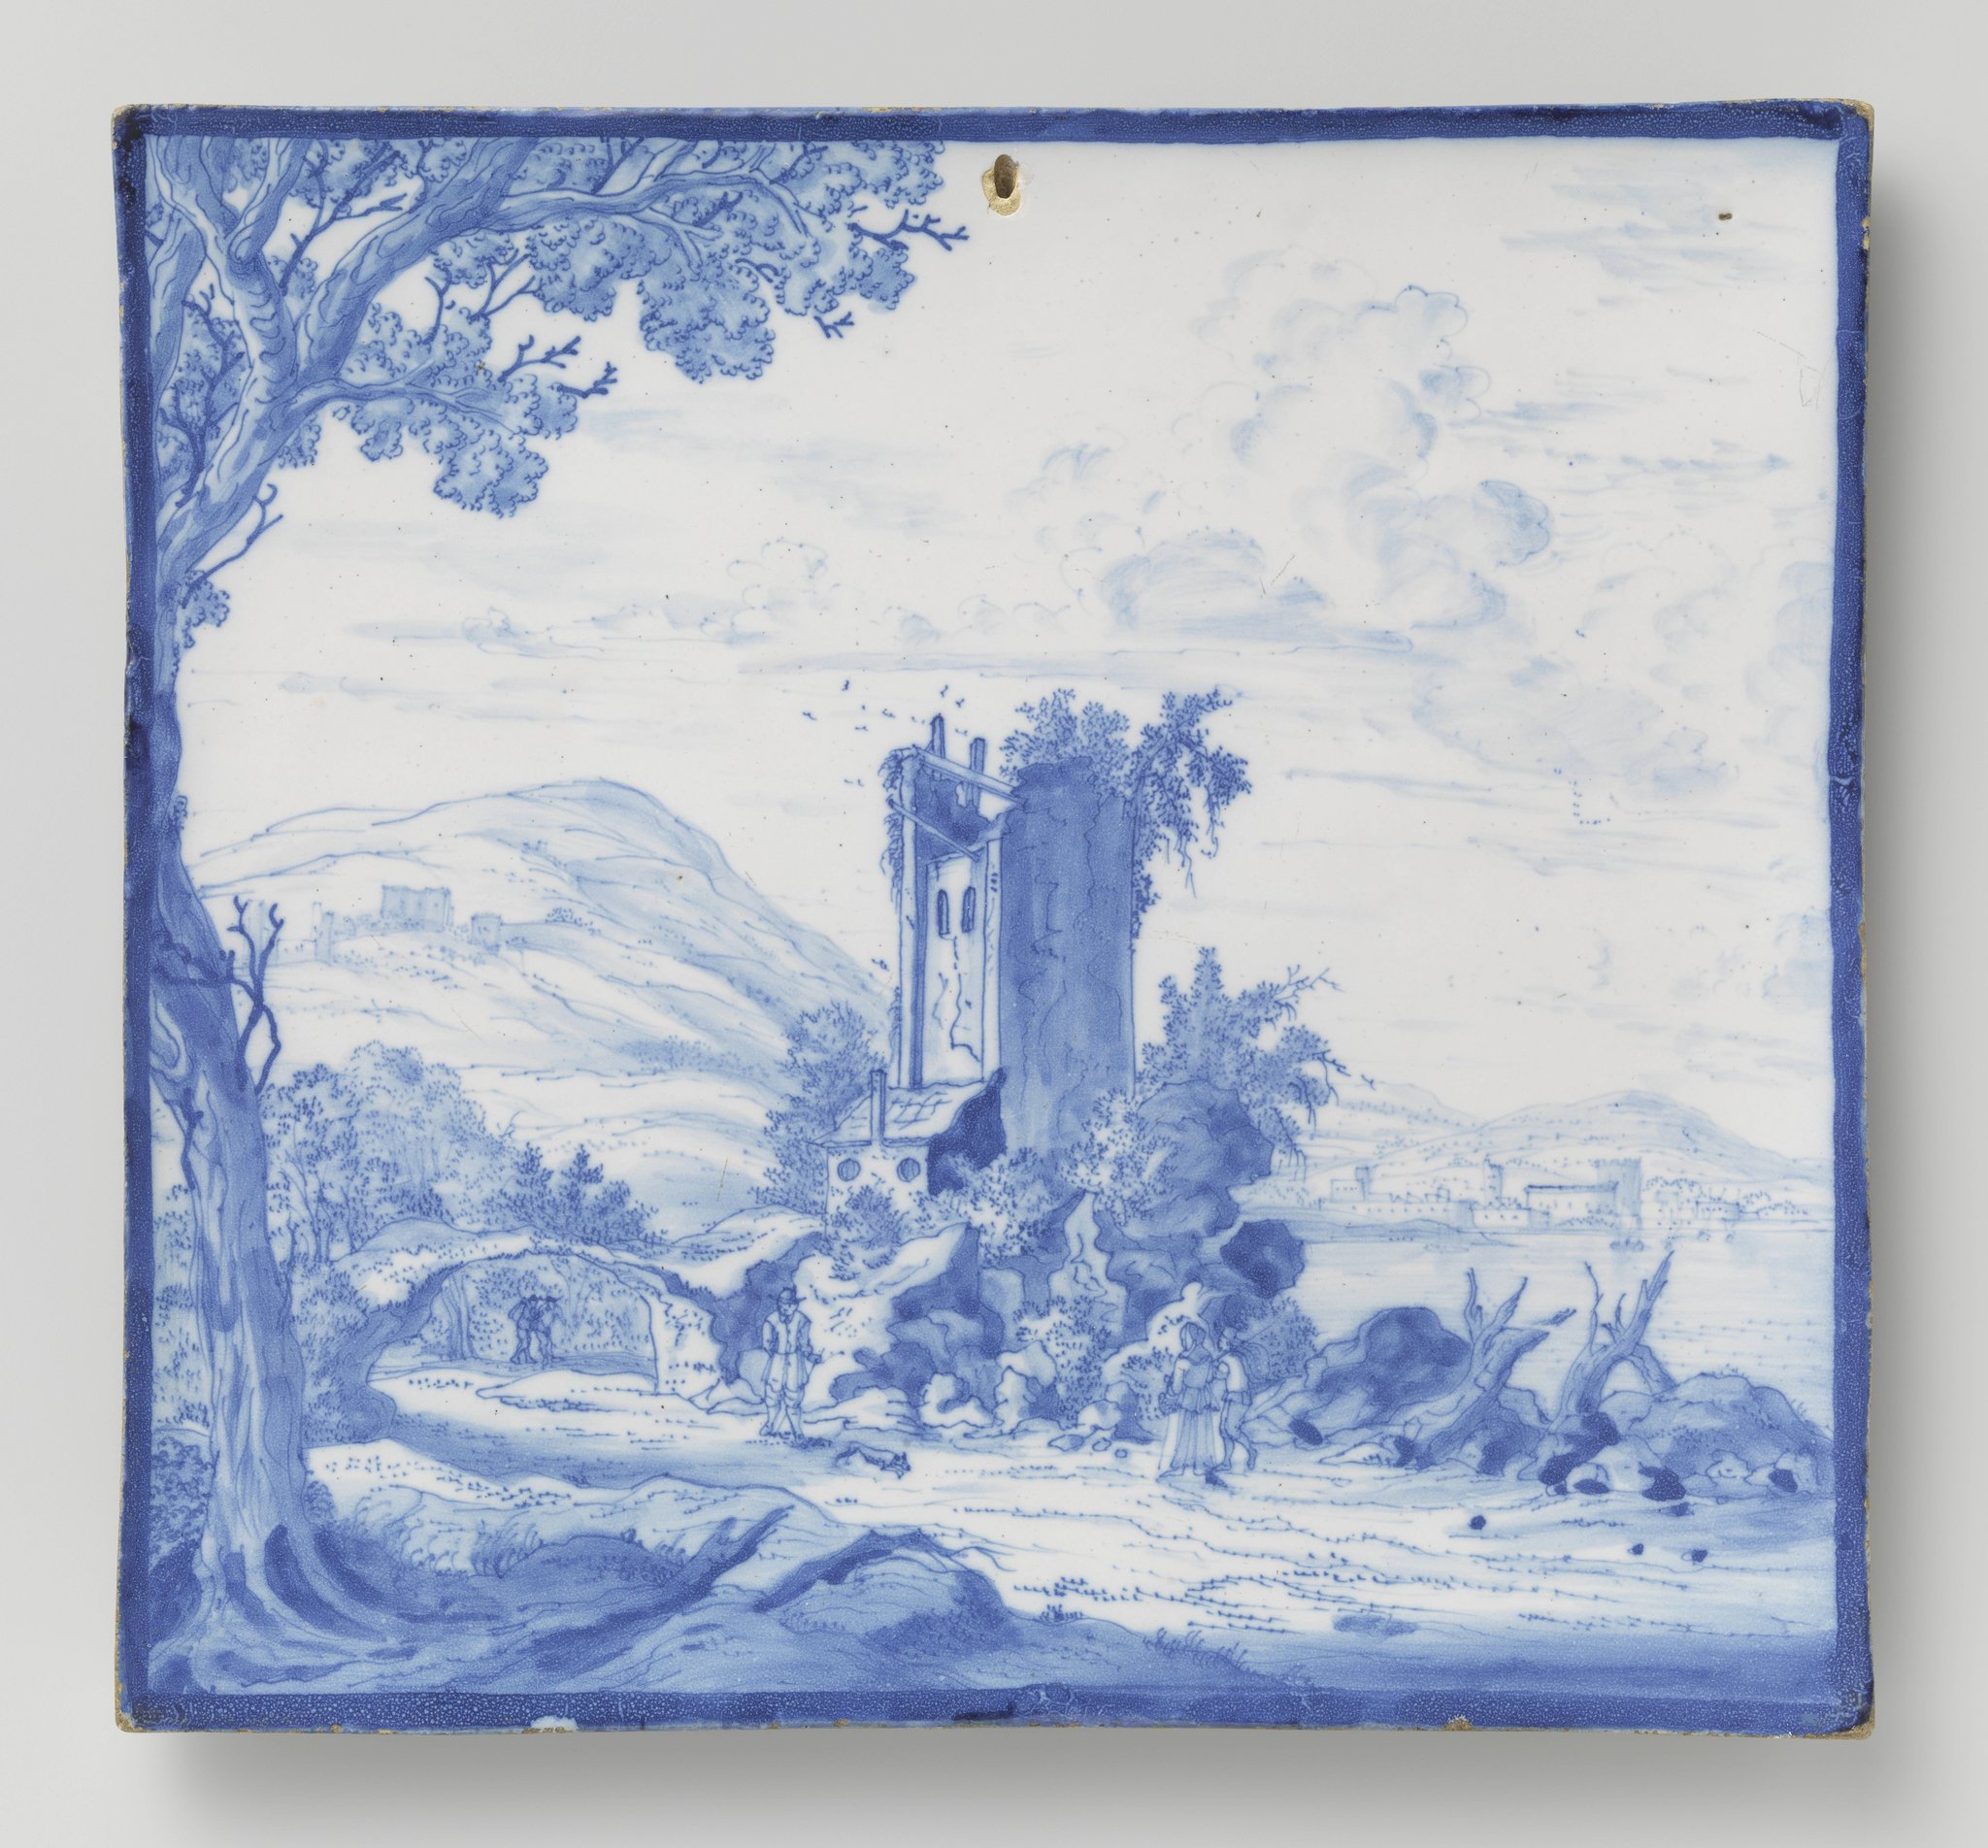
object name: plate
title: Plaque with a ruin and figures in a landscape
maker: Anonymous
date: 1650-1680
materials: earthenware, glaze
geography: delft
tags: landscape with ruins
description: Plaat van faience met een Italianiserend landschap: op roomwitte fond in blauw een bergachtig landschap met op de voorgrond links een boom; in het midden een bouwval van een toren en enkele figuren.